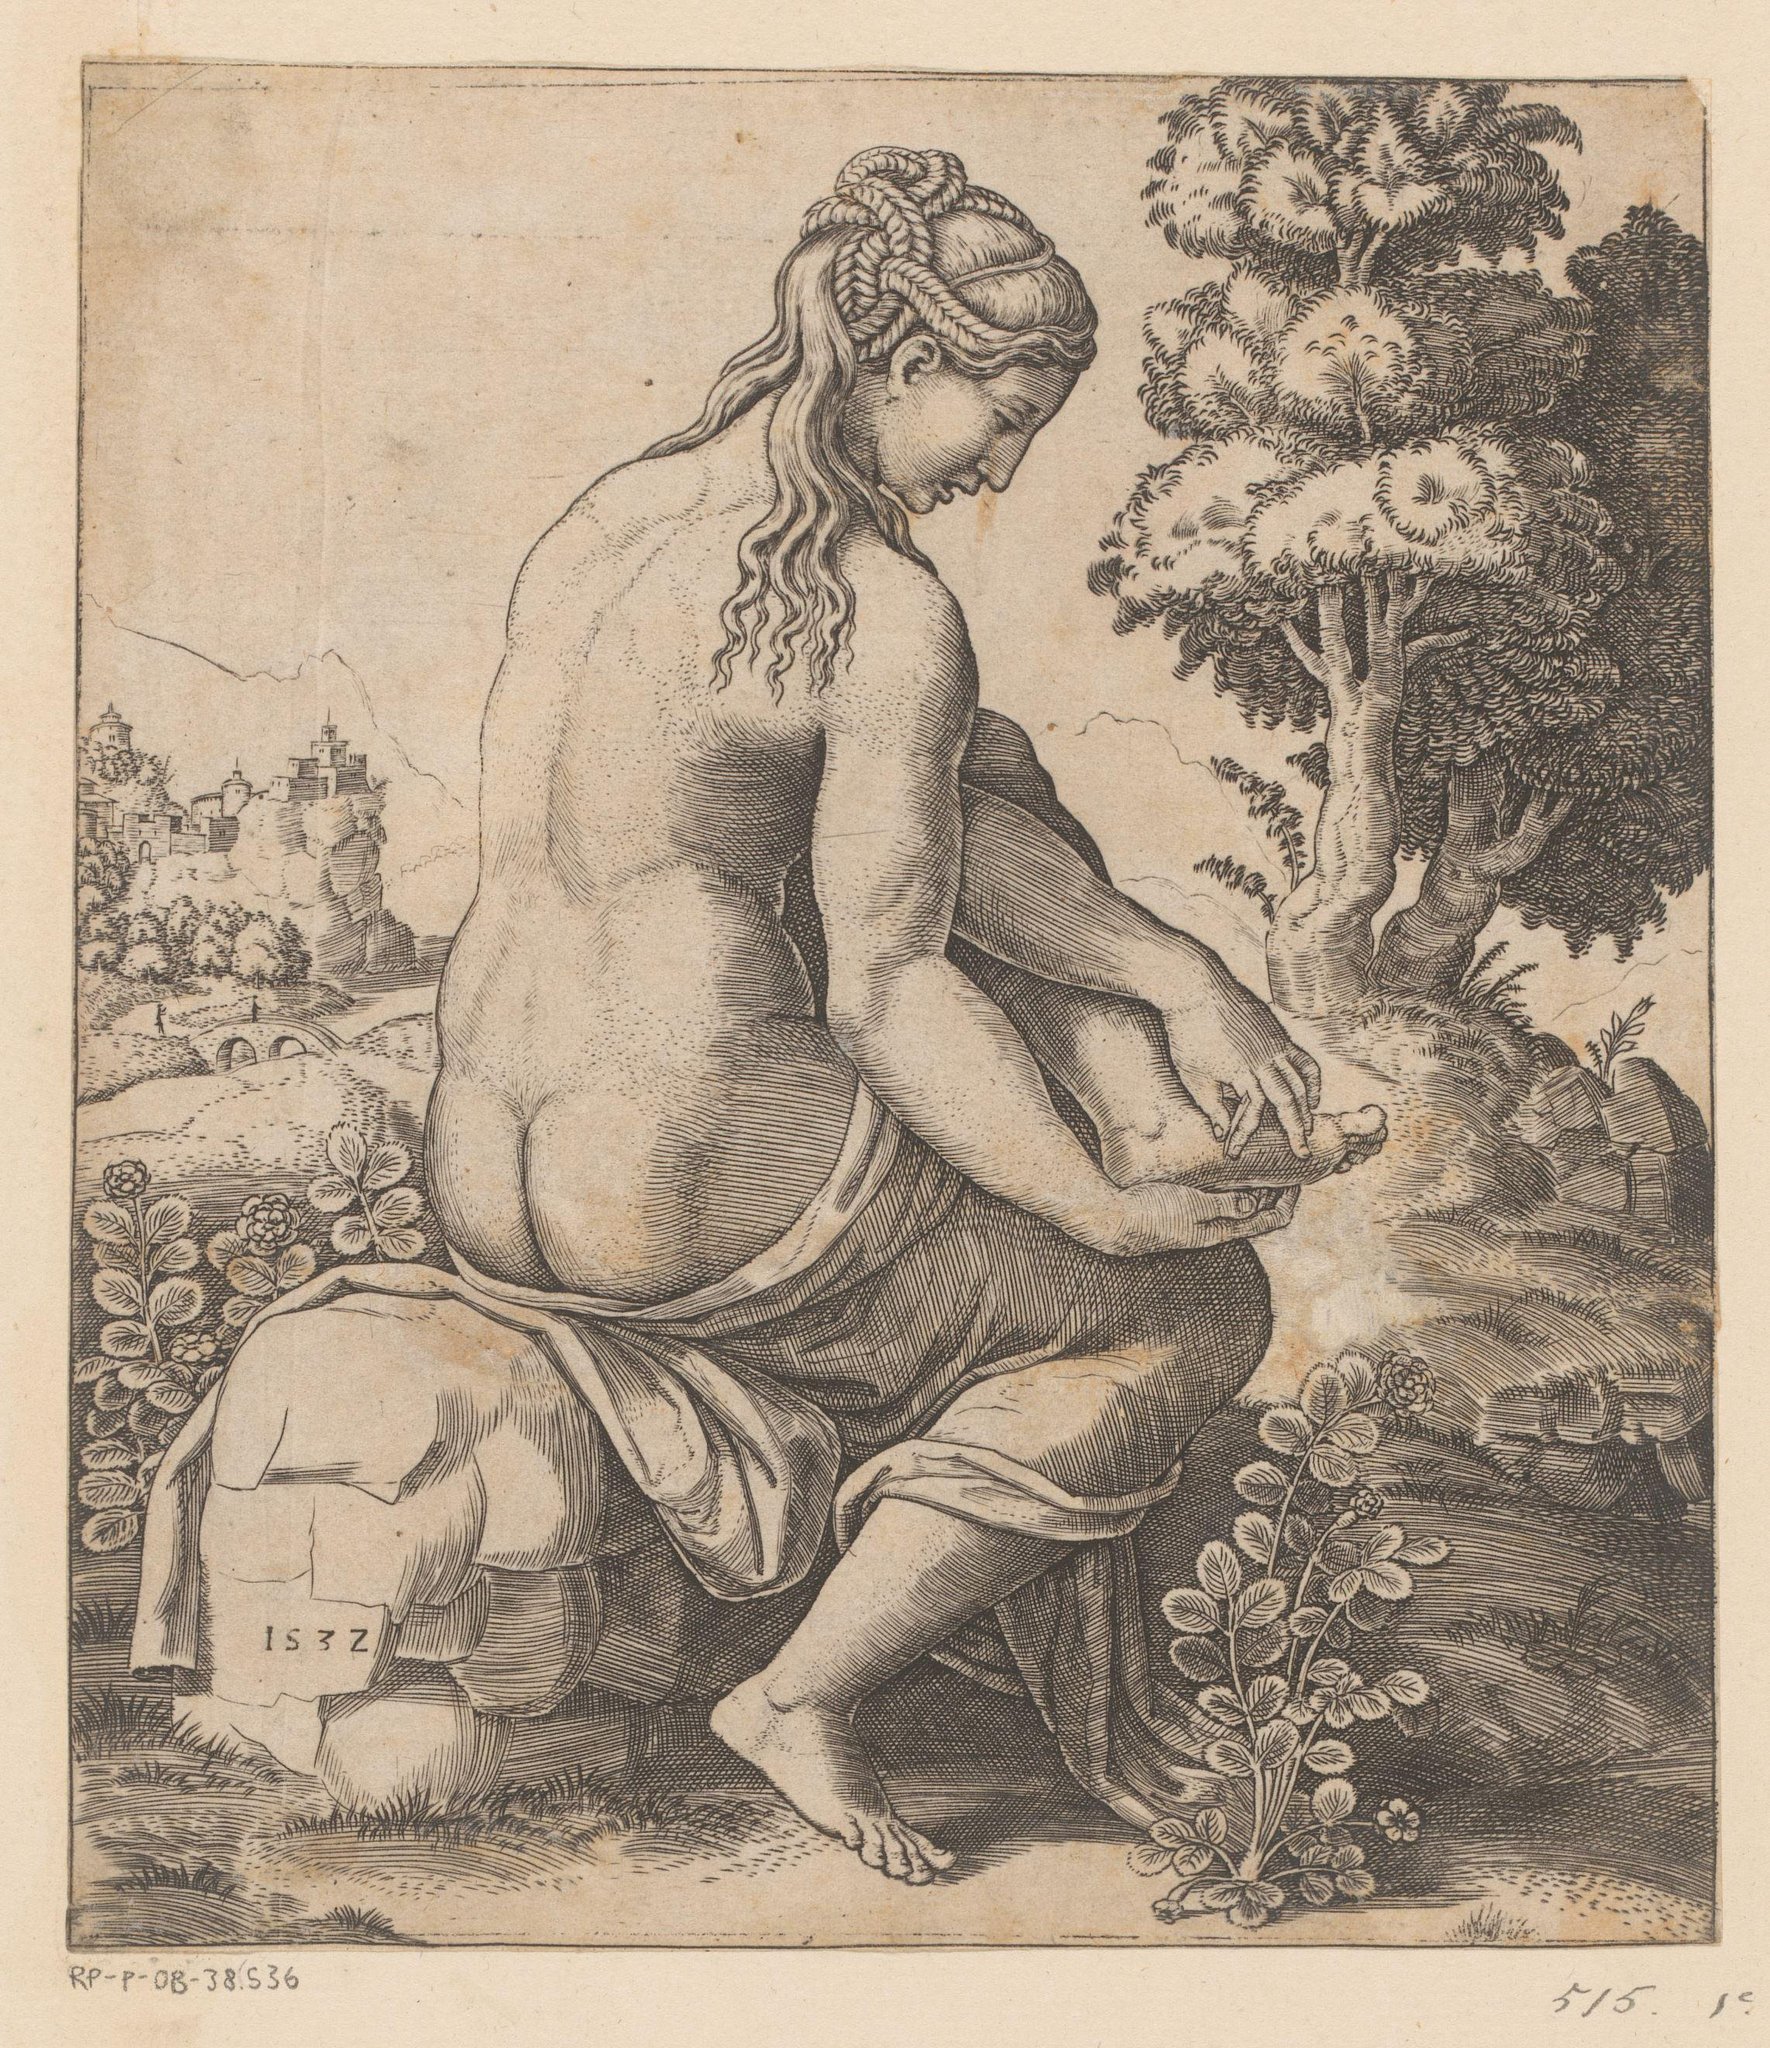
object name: print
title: Venus en de roos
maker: meester van de dobbelsteen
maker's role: print maker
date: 1532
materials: paper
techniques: engraving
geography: italy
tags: city-view, and landscape with man-made constructions, venus wounded by the thorns of a rose-bush; the roses change from white to red (possibly combined with the story of adonis)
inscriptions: date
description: Venus zit op een rots in een landschap. Ze haalt een doorn van een rozenstruik uit haar voet.